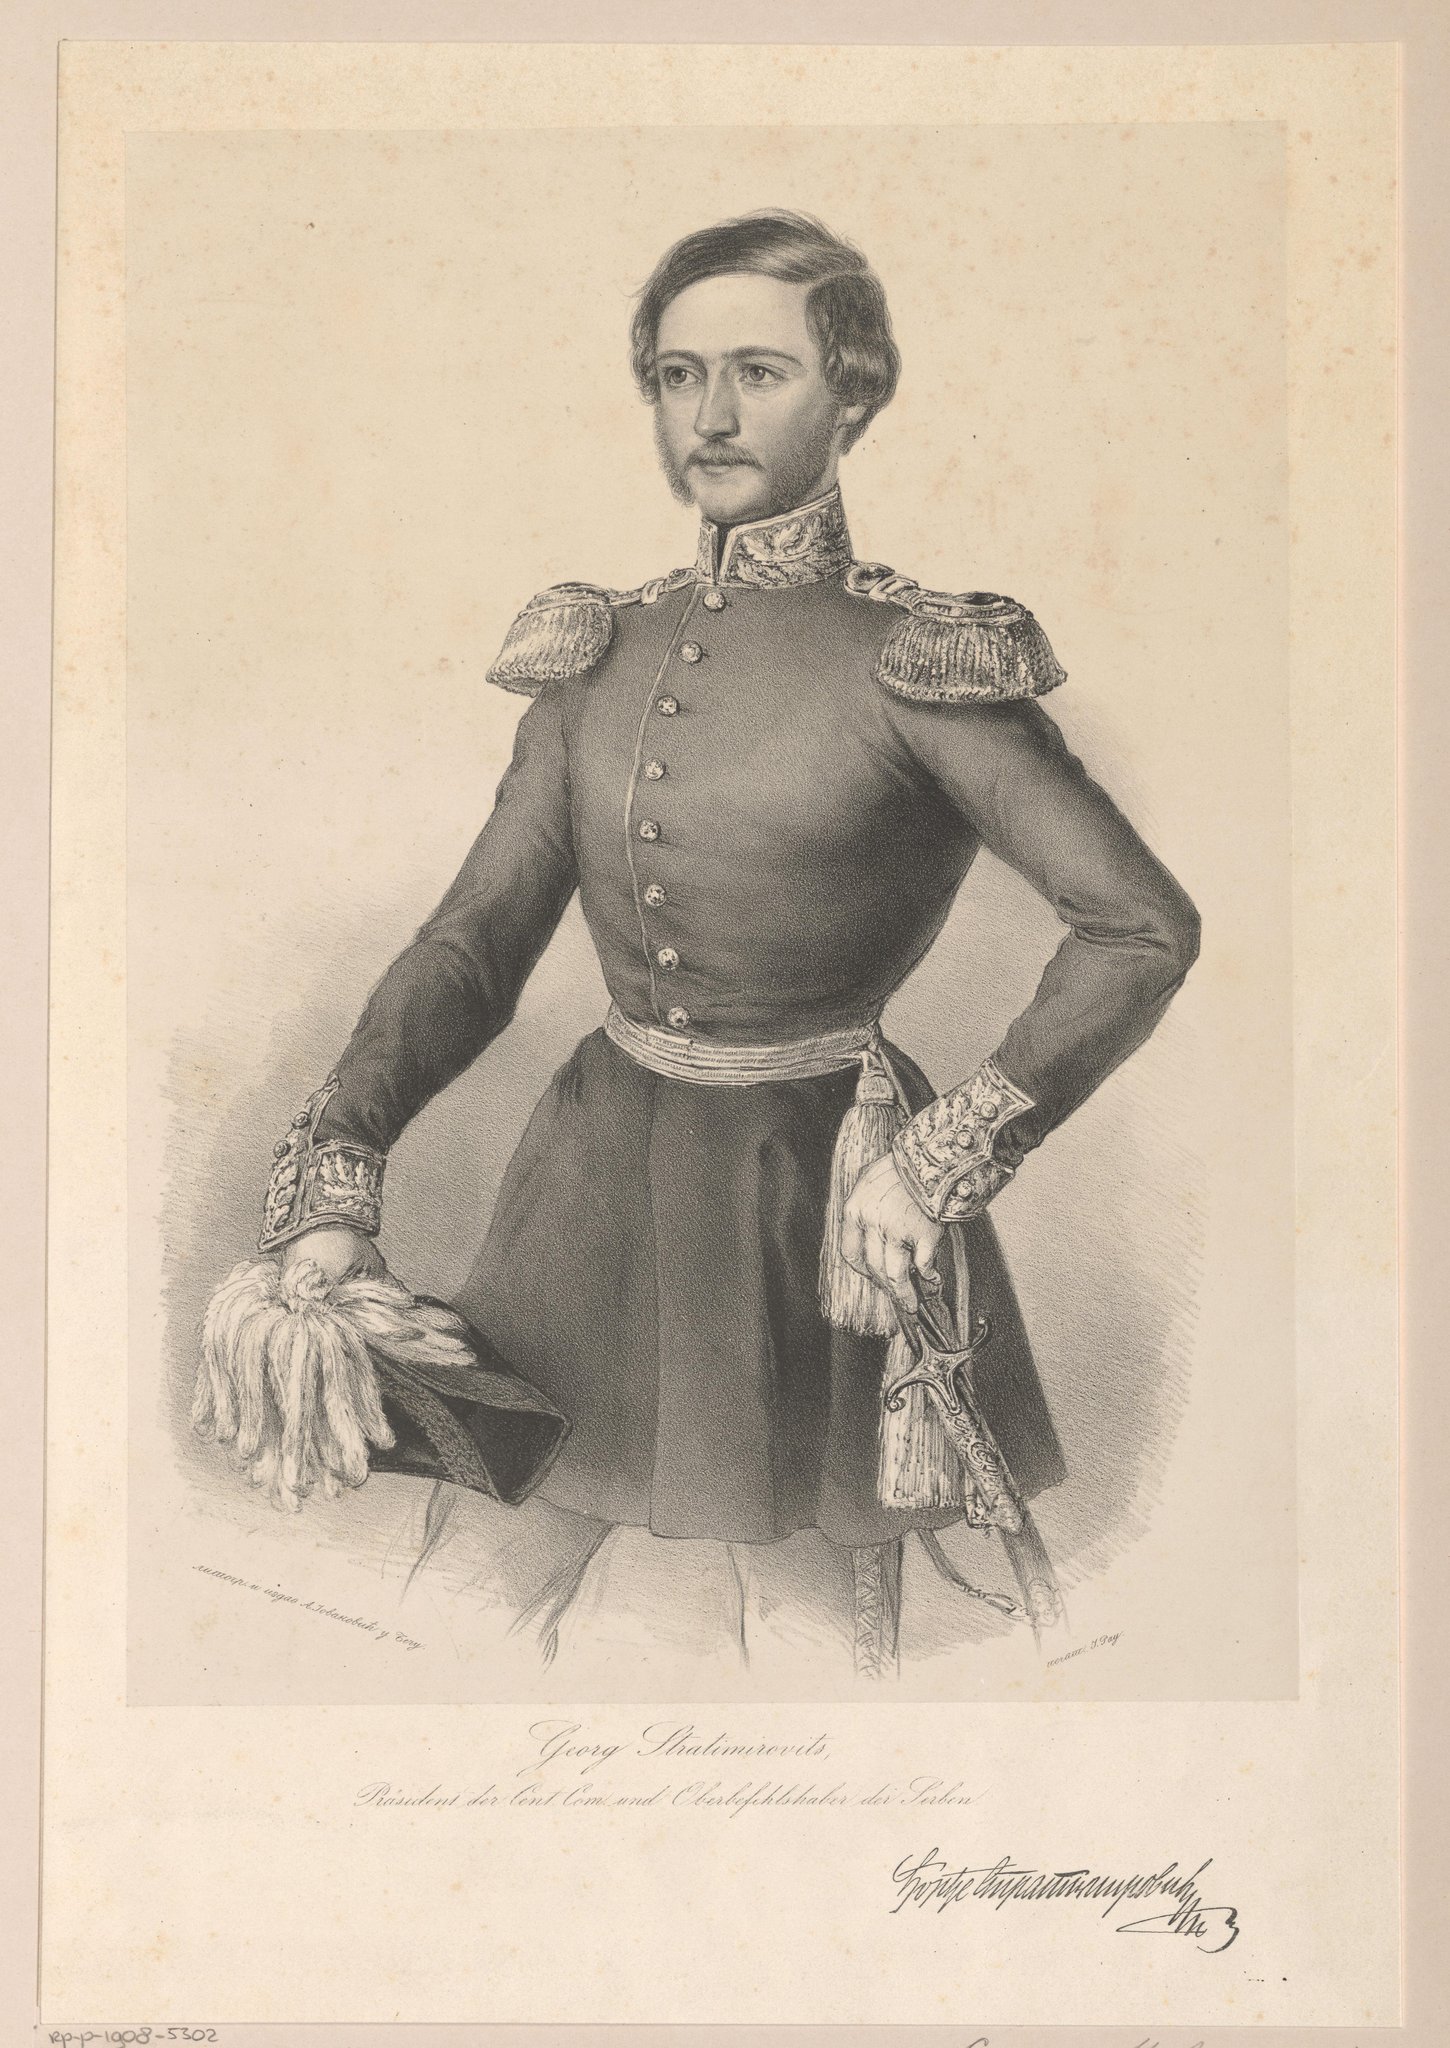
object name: print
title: Portret van Đorđe Stratimirović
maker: Anonymous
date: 1849-1899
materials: paper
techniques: lithograph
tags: vienna, politician, commander-in-chief, general, marshal, historical persons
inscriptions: collector's mark: Lugt 2228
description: Met eenregelig onderschrift in het Duits.